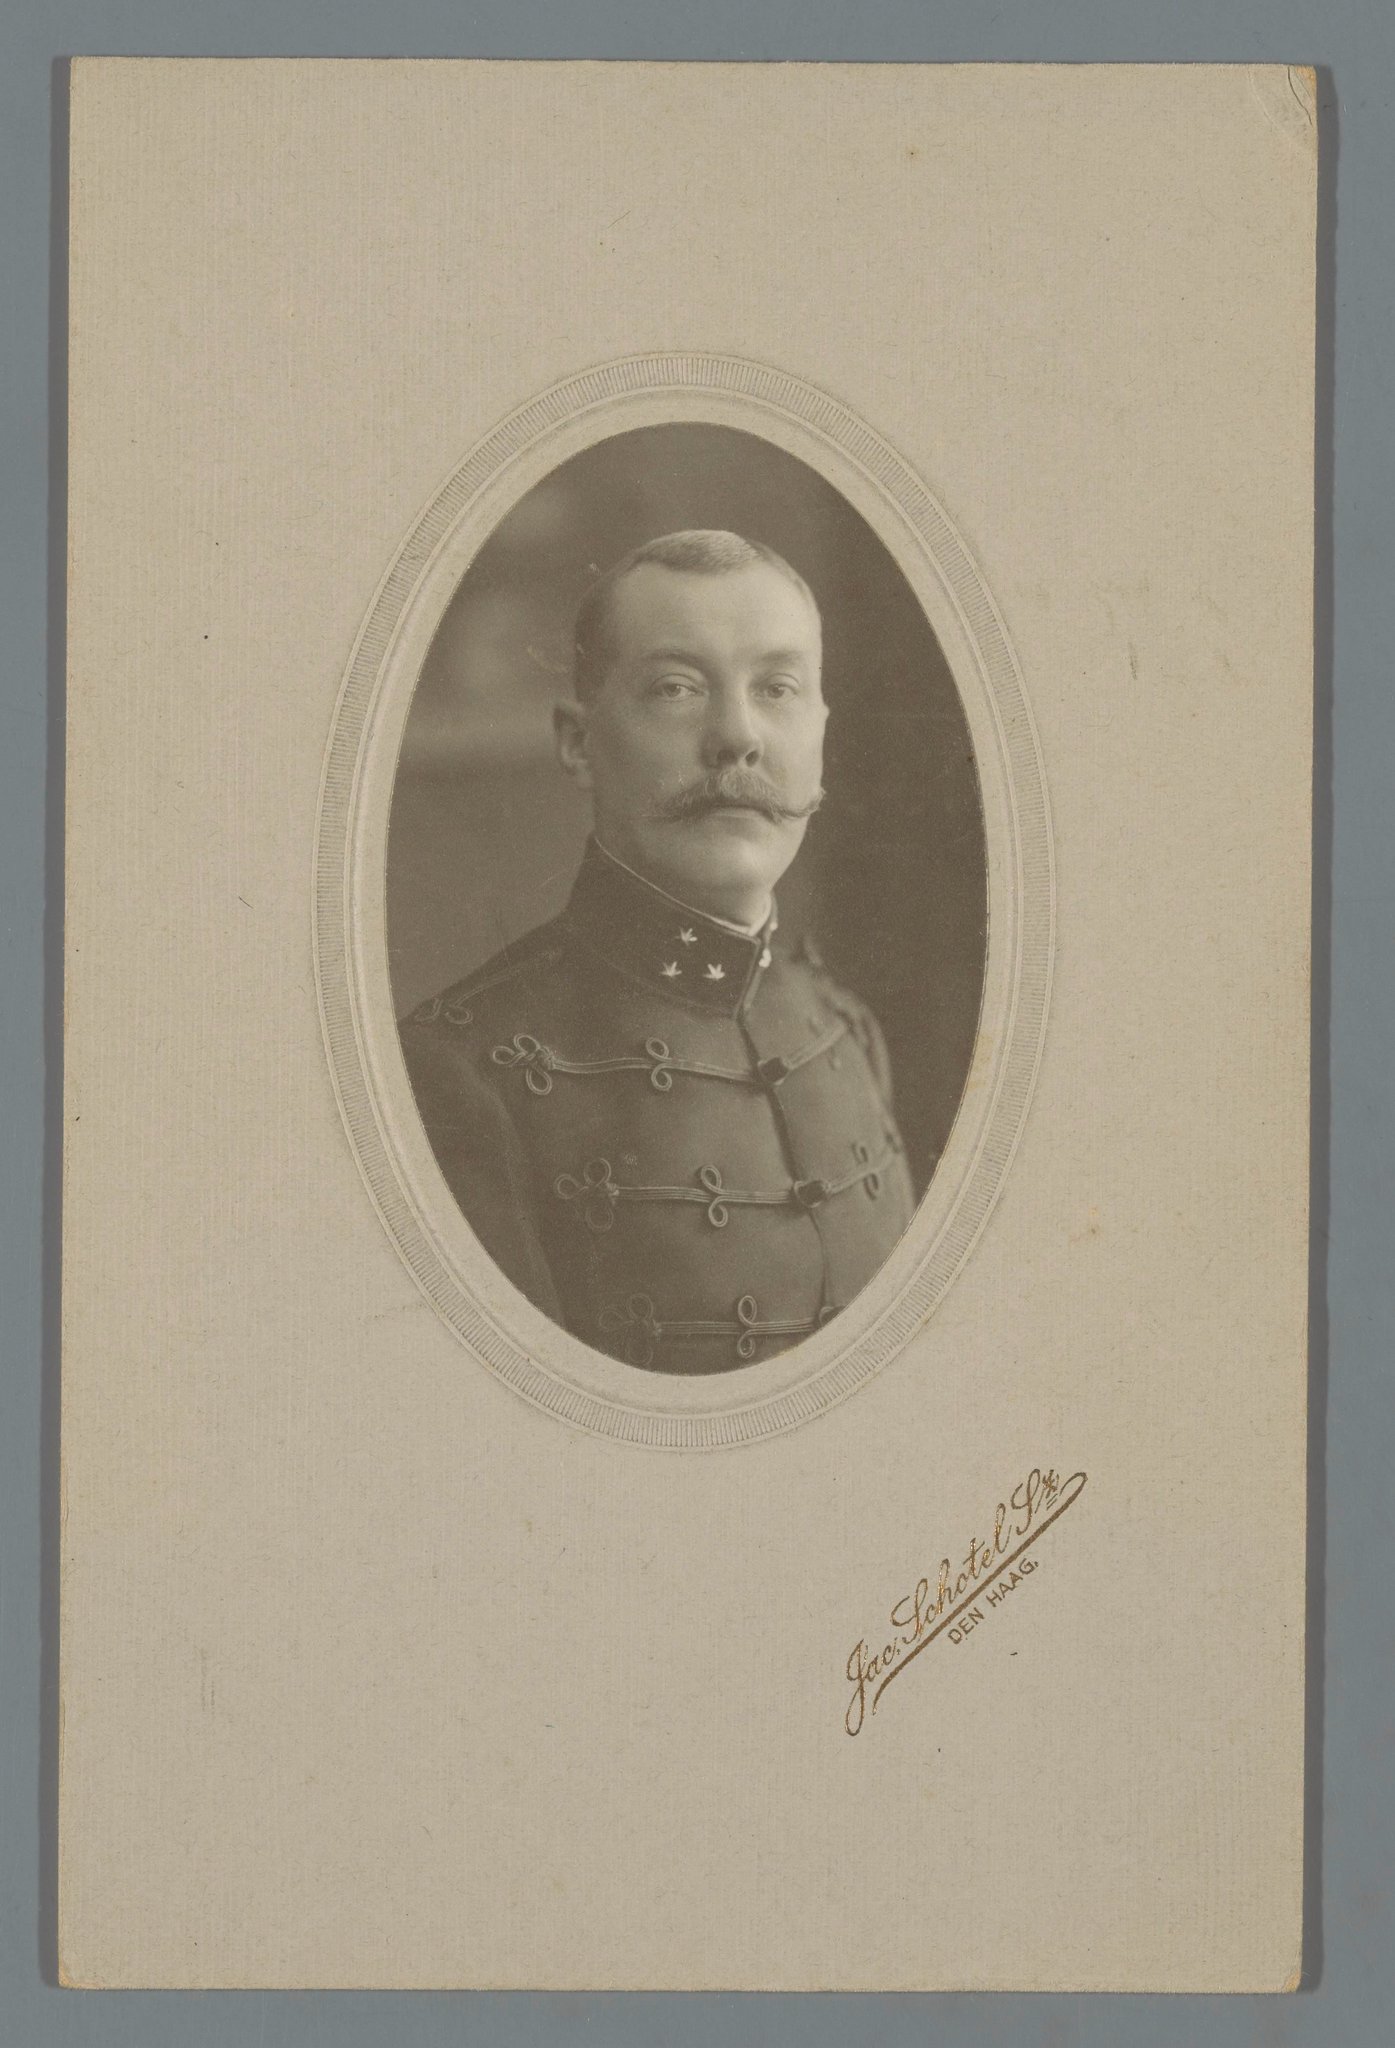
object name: cabinet photograph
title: Portret van een militair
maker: jac. schotel szn.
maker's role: fotograaf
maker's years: 1868-1955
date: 1900-1920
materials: cardboard, photographic support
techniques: matte daylight collodion silver print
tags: private soldier, (military) uniforms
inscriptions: : ‘Den Haag’